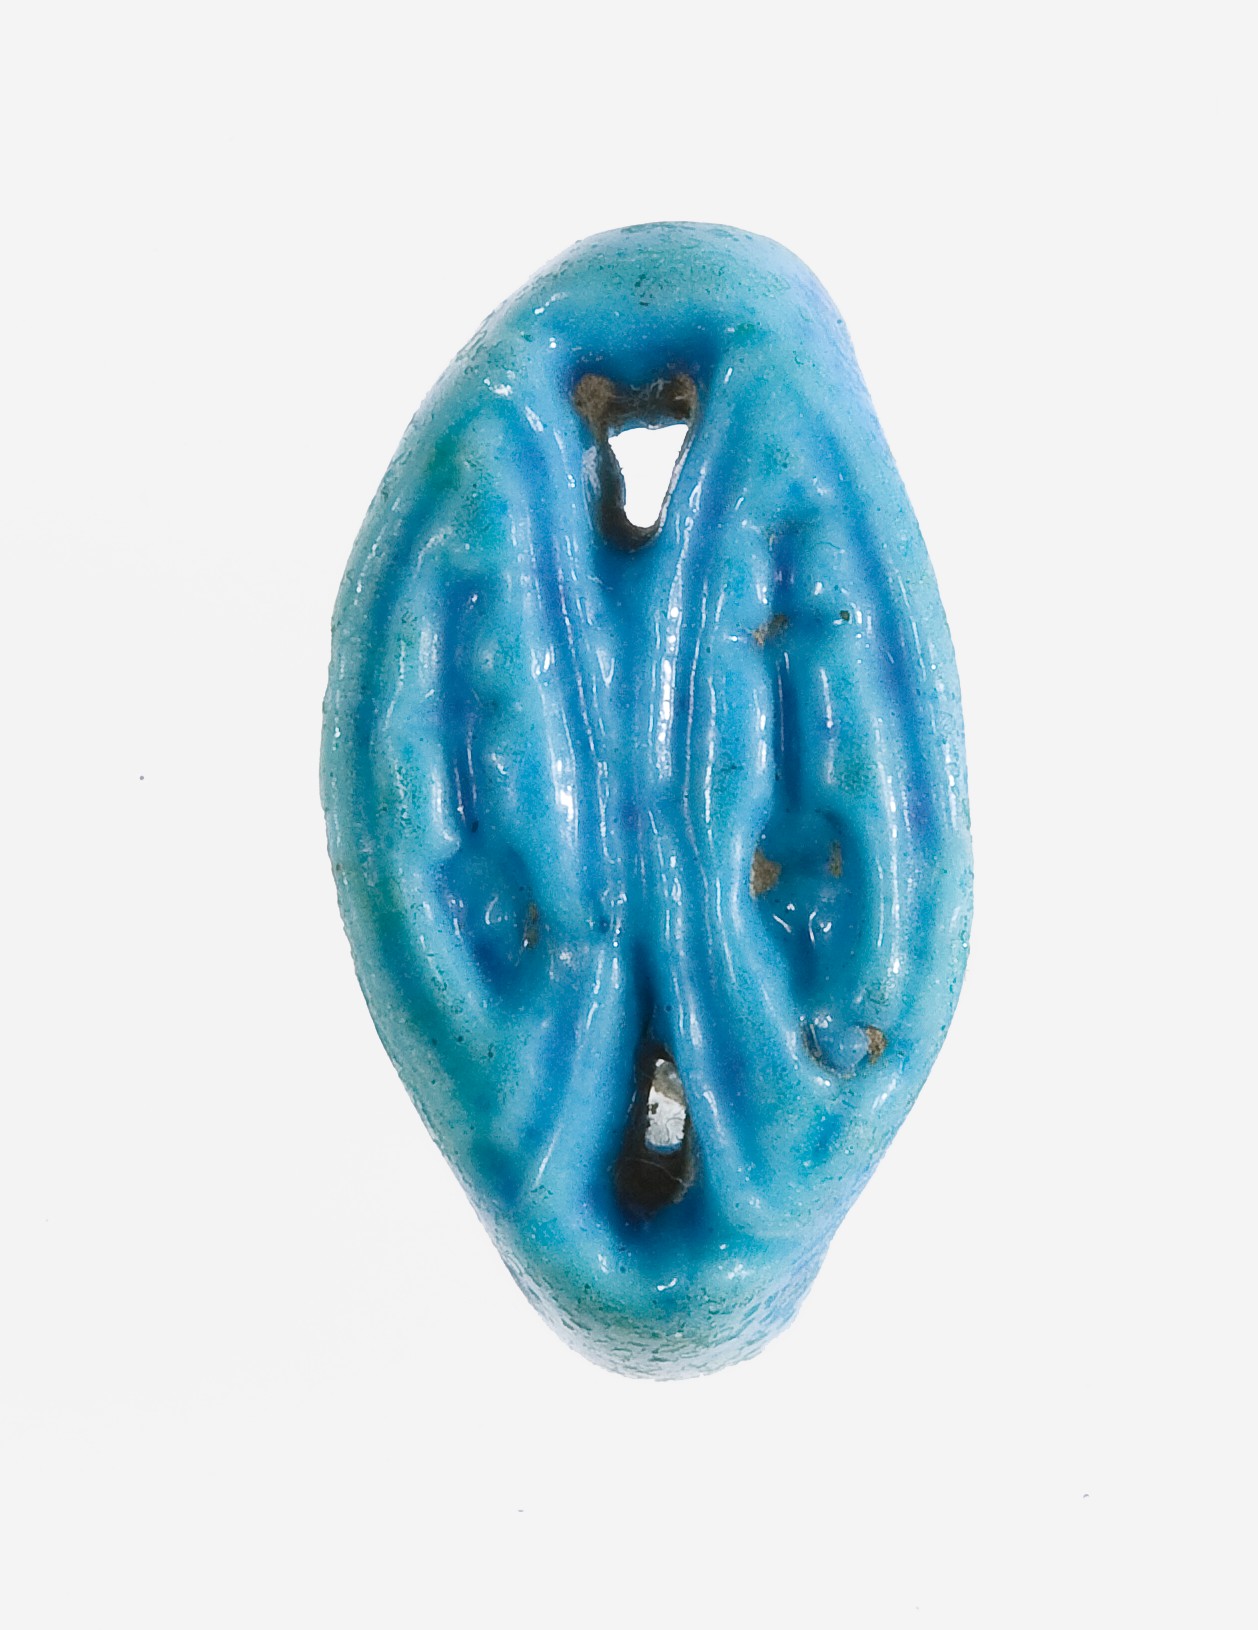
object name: ring fragment, maat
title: Ring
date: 1390-1352 BCE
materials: faience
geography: egypt